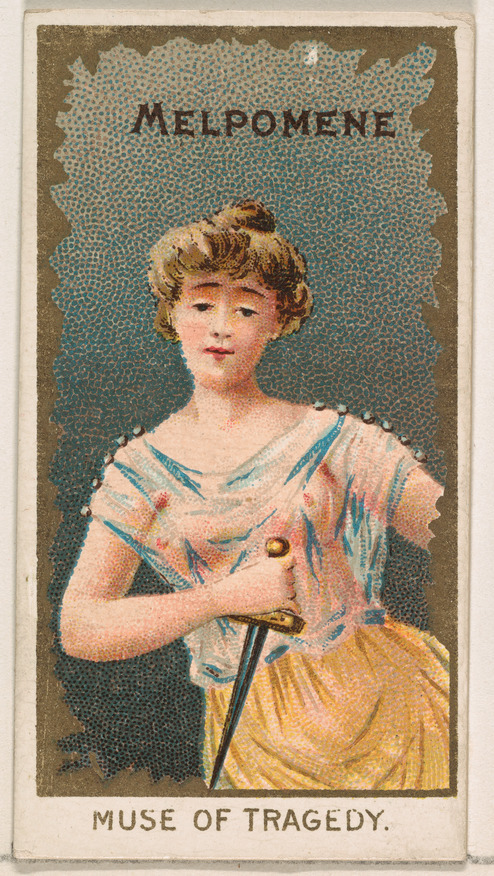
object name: print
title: Melpomene, Muse of Tragedy, from the Goddesses of the Greeks and Romans series (N188) issued by Wm. S. Kimball & Co.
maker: william s. kimball & company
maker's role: publisher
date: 1889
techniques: color lithograph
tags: women,muses